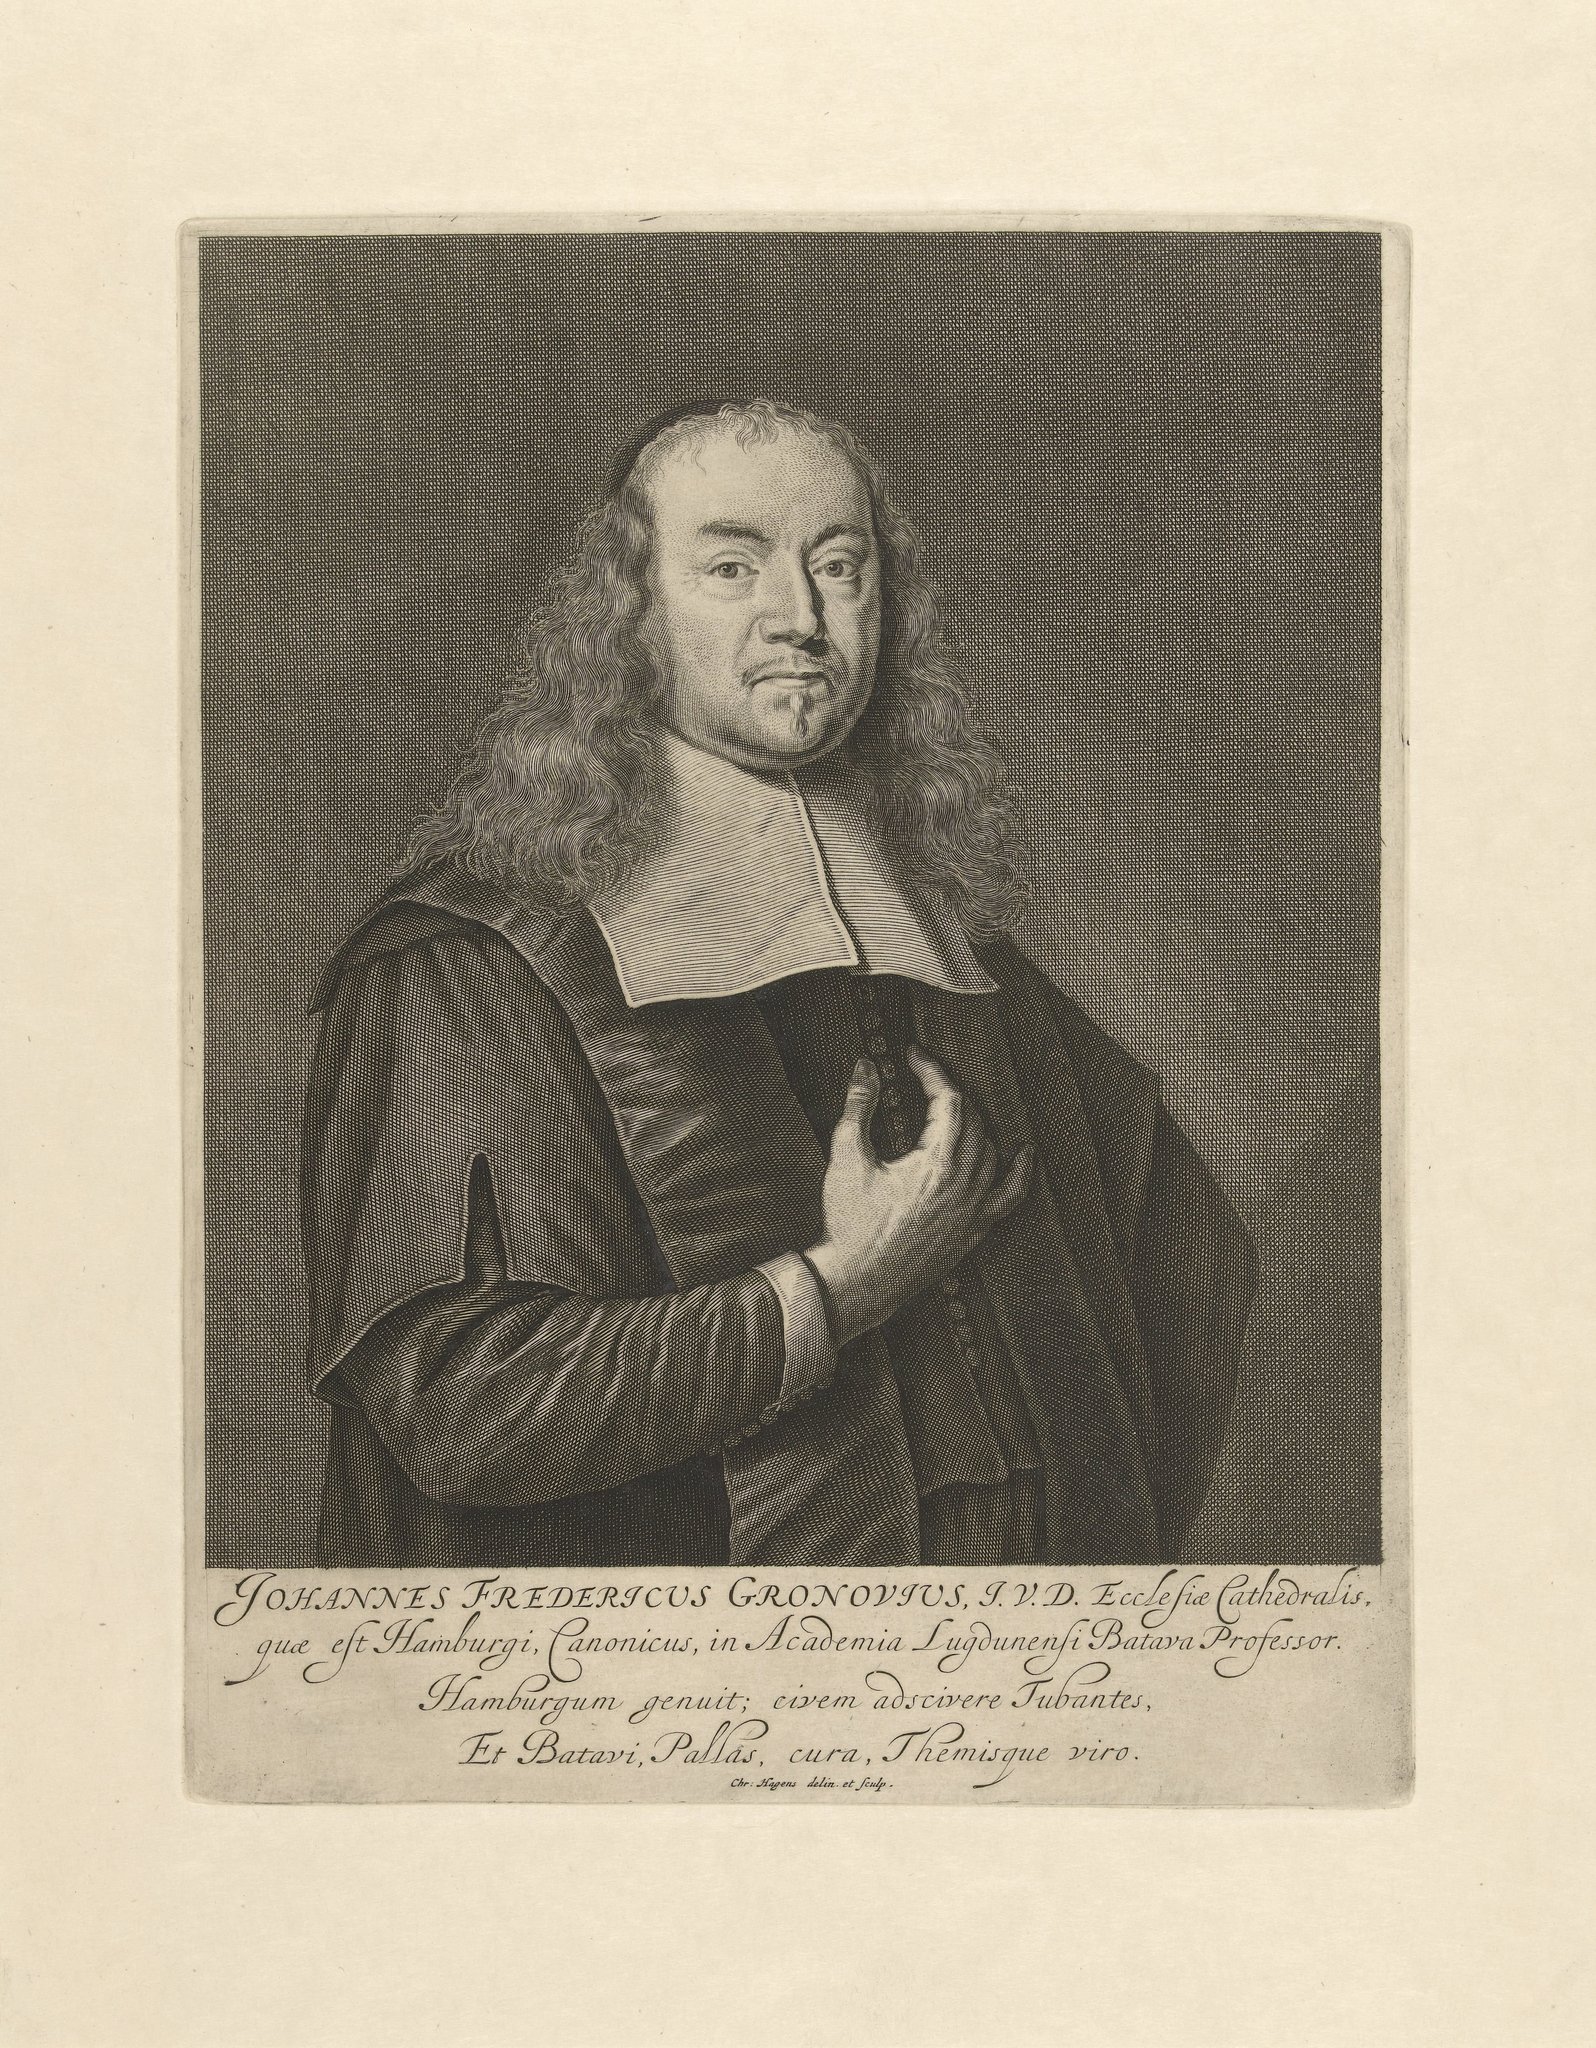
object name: print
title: Portret van Johannes Fredericus Gronovius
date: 1917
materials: paper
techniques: engraving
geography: amsterdam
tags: leiden, johann friedrich gronovius, moustache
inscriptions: collector's mark: Lugt 2233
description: Portret ten halven lijve naar rechts van de schrijver Johannes Fredericus Gronovius, met onder zijn portret een vierregelige tekst in het Latijn.